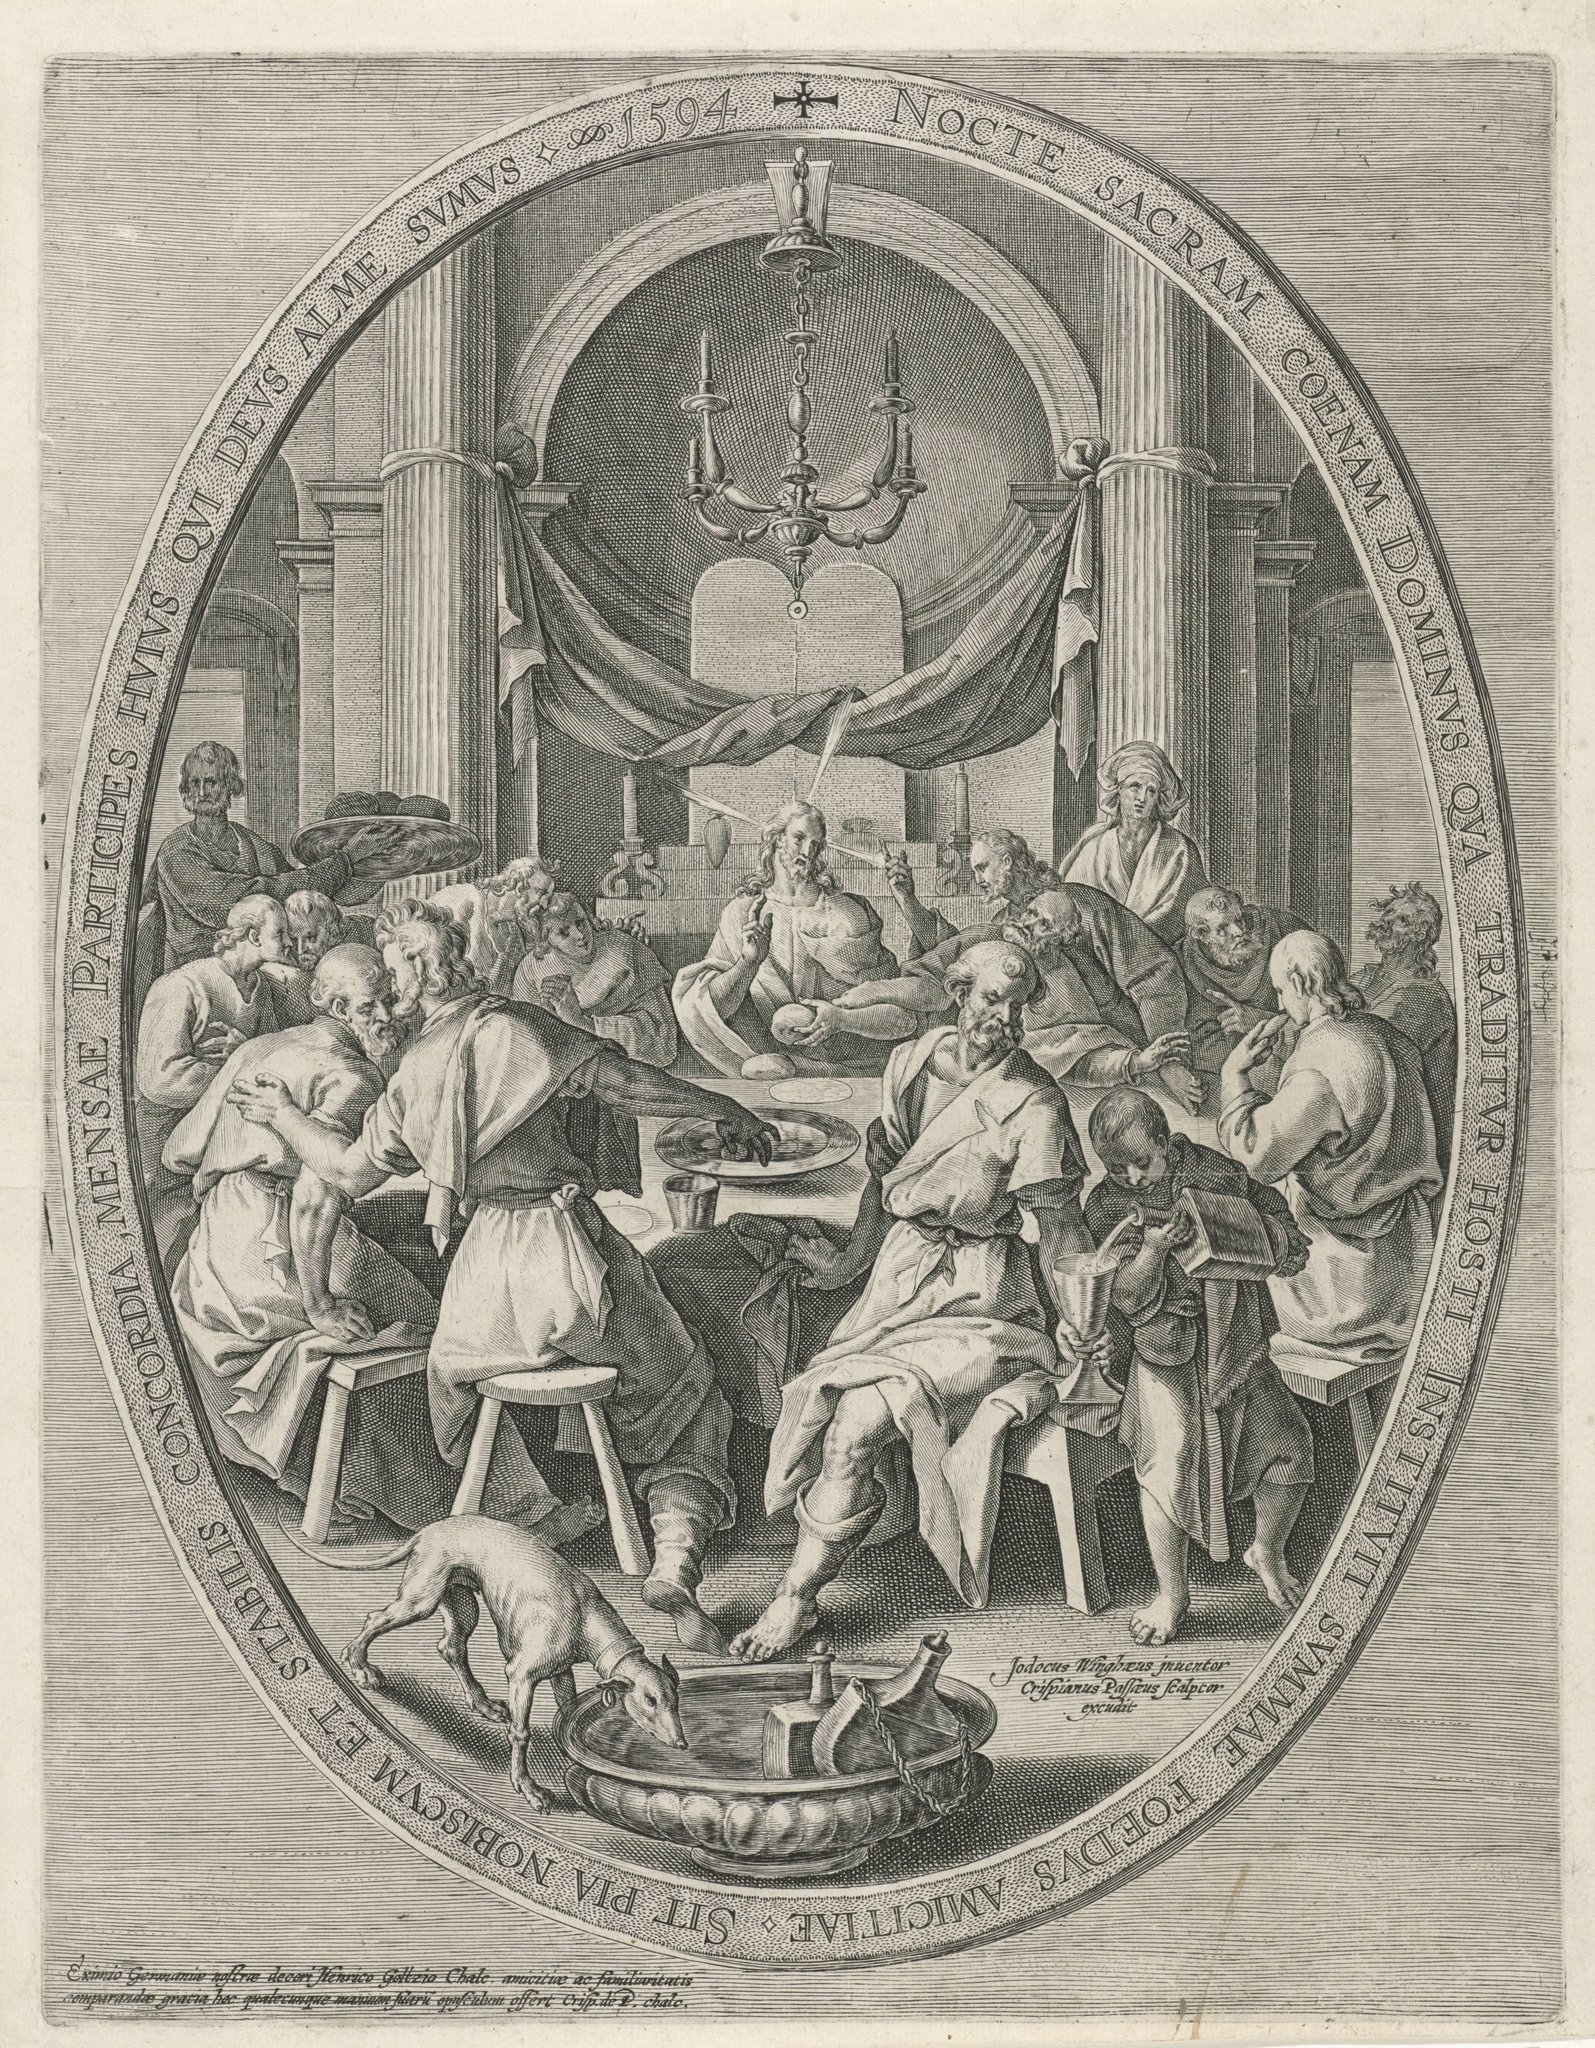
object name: print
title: Laatste Avondmaal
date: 1594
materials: paper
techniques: engraving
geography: cologne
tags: institution of the eucharist, i.e. christ showing or blessing bread (host) and/or wine (matthew 26:26-27; mark 14:22-23; luke 22:19-20; john 13:26; 1 corinthians 11:23-25), last supper (in general) (matthew 26:21-35; mark 14:18-31; luke 22:3, 22:15-23; john 13:21-38)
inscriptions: collector's mark: Lugt 2228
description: Christus en zijn leerlingen zitten rond een tafel. Christus houdt het brood vast en maakt een zegenend gebaar. Op de achtergrond op een altaar staan de tafelen der wet. De voorstelling is gevat in een ovale omlijsting met een randschrift in het Latijn.